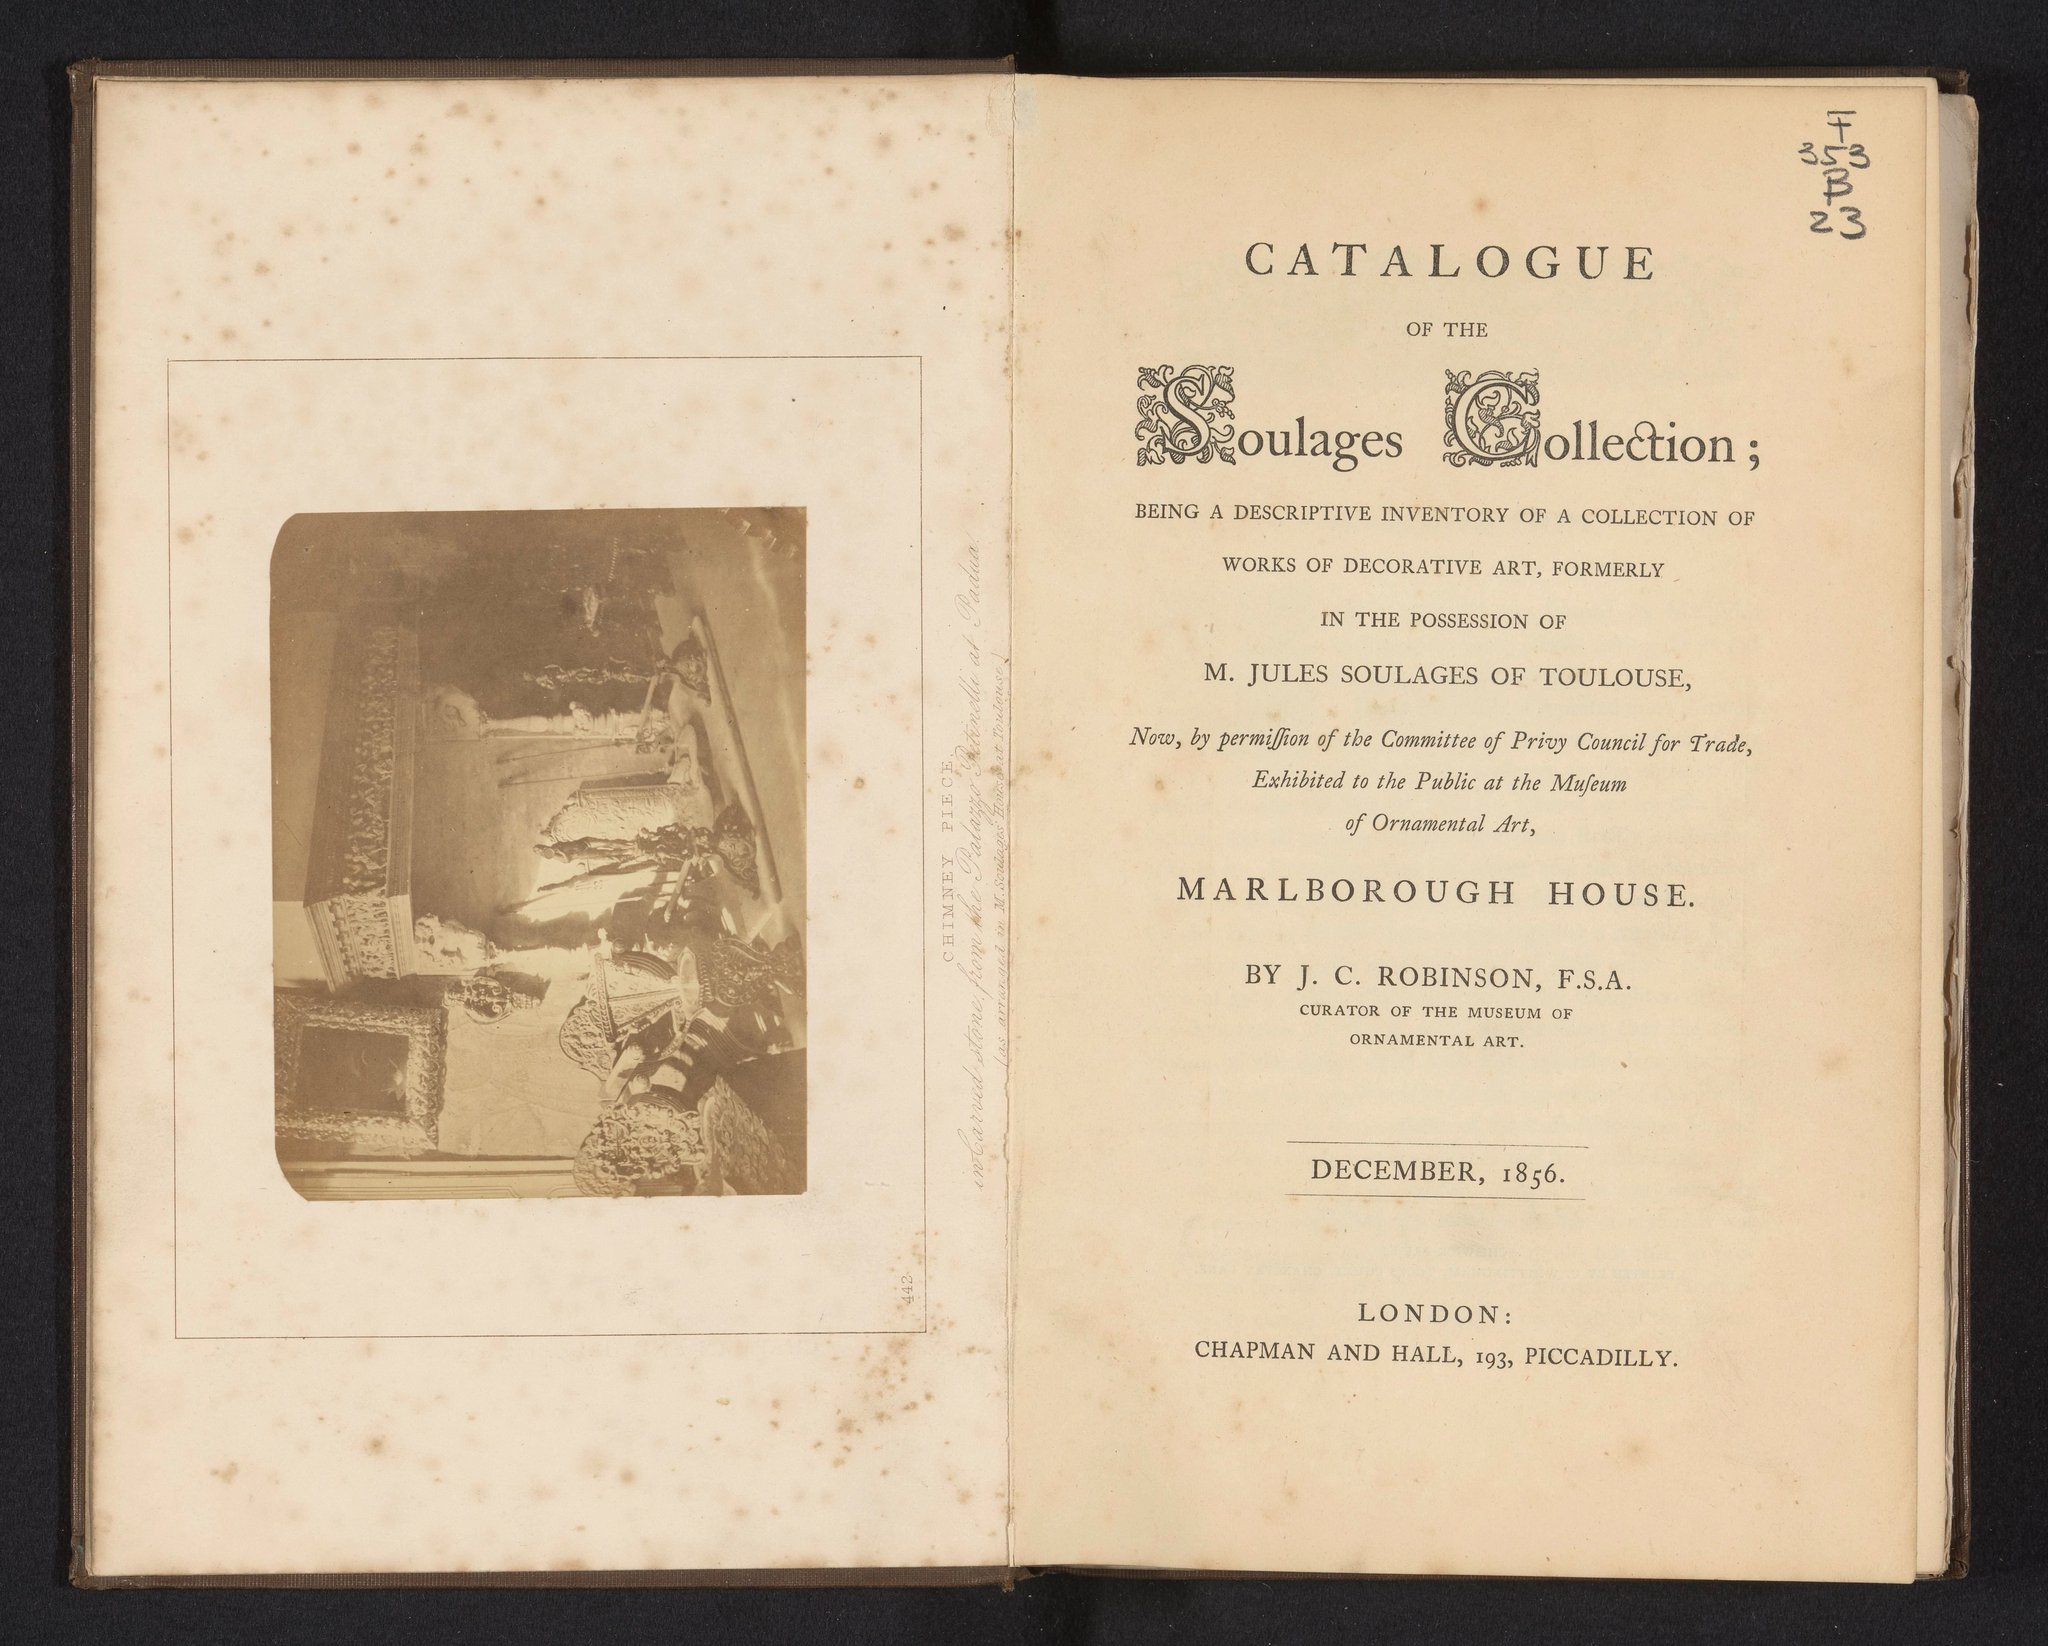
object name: photograph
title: Schoorsteenmantel uit Padua in het huis van Jules Soulages in Toulouse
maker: Anonymous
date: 1855-1856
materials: photographic support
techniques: albumen print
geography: toulouse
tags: chimney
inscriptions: inscription: ‘incarved stone from the Palazzo Petinelli at Padua (as arranged in M. Soulages House at Toulouse)’, number: ‘442’